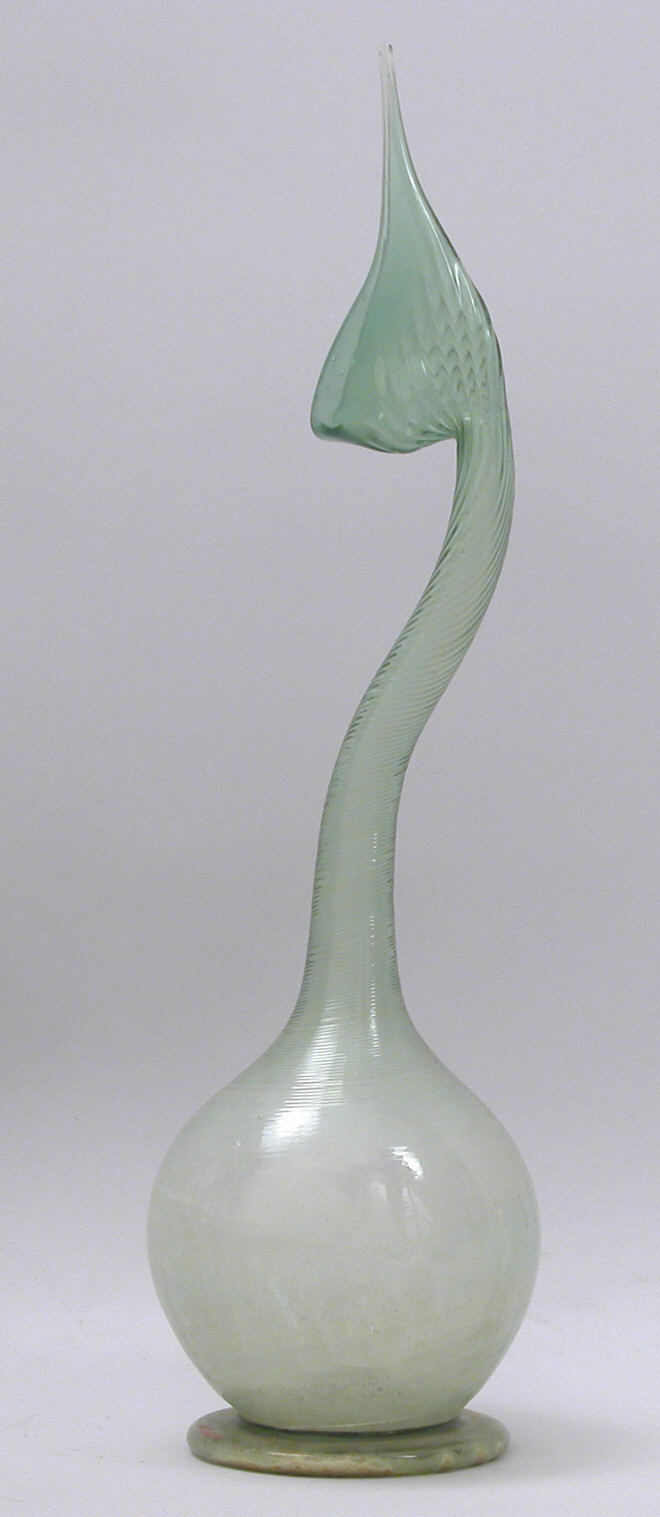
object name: bottle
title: Swan-neck Bottle (Ashkdan)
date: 1801-1900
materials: glass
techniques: glassblowing, molding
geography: iran